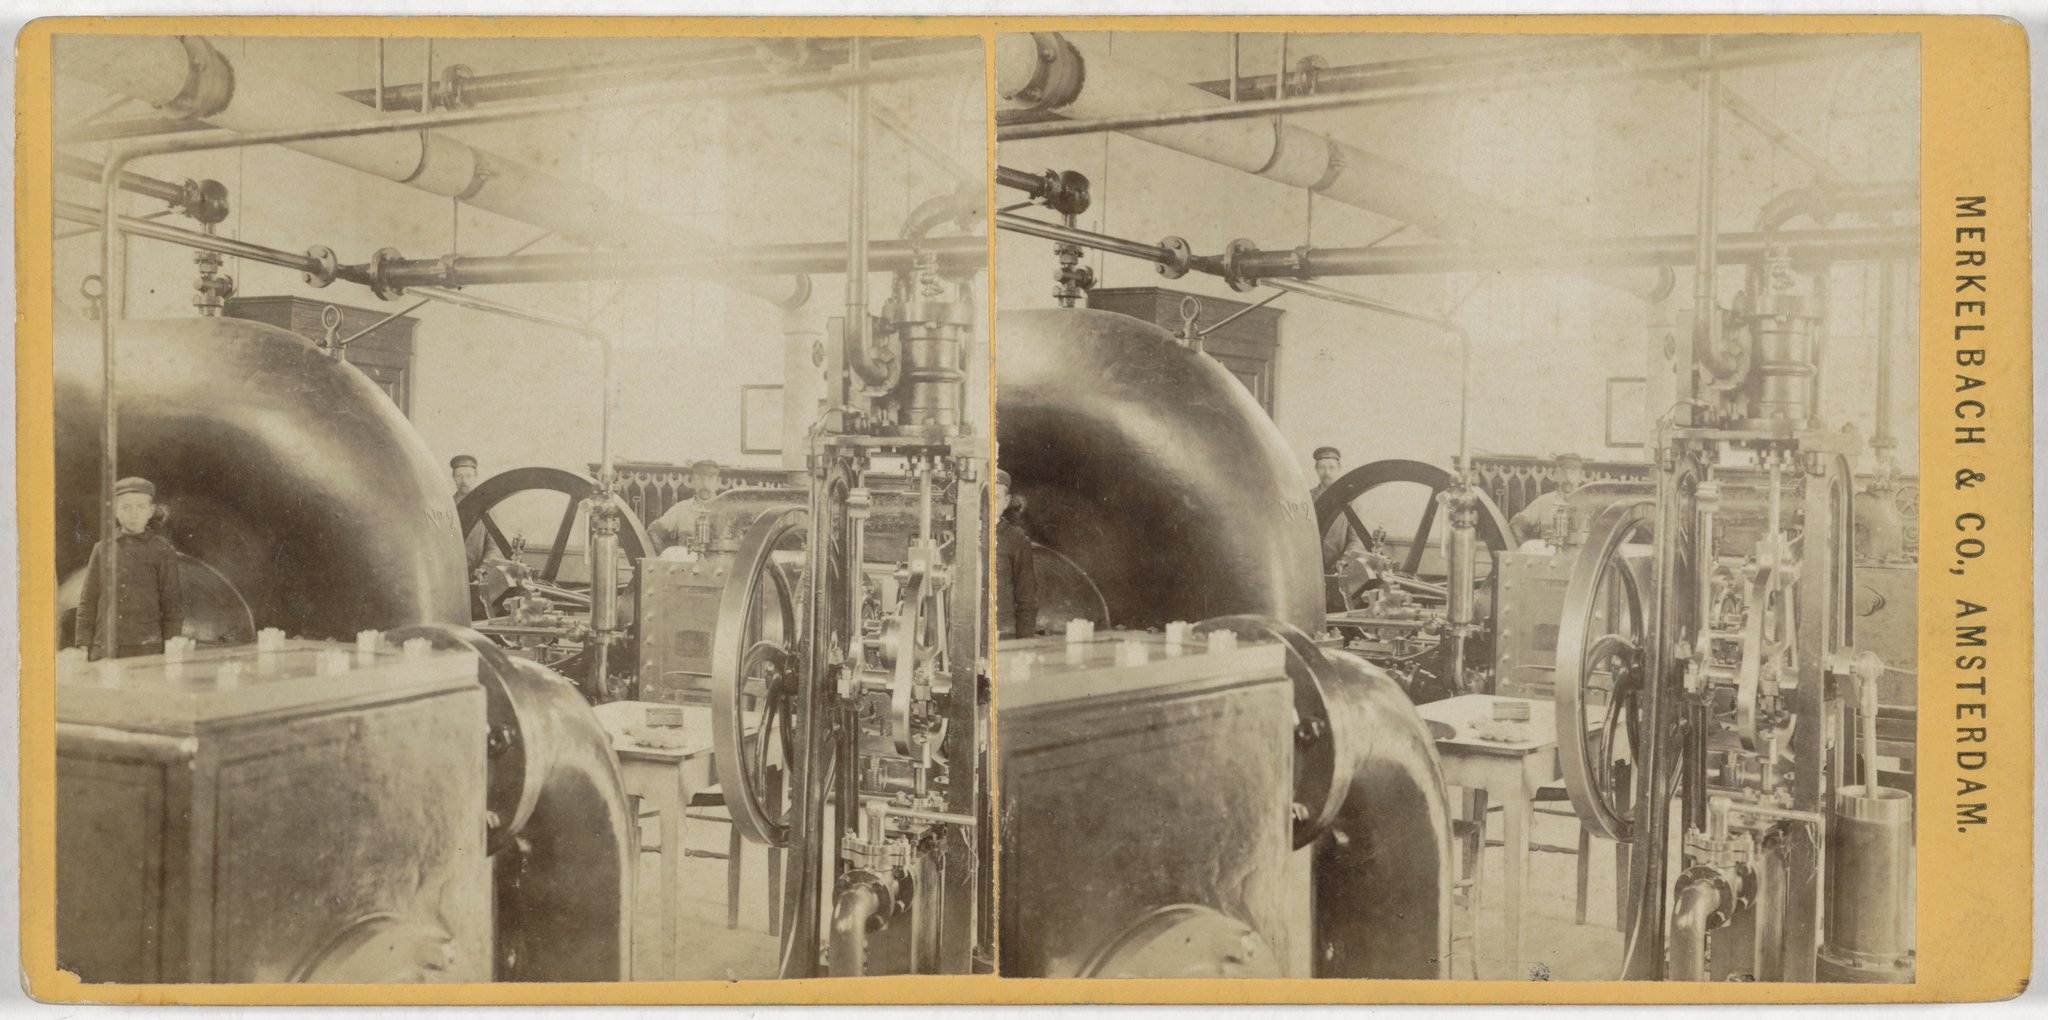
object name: stereograph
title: Interieur van een watermachine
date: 1900-1902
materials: cardboard, paper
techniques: albumen print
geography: netherlands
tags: machine driven by water, netherlands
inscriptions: inscription: ‘RBK’, inscription: ‘Interieur van een watermachine.’, number: ‘5.’